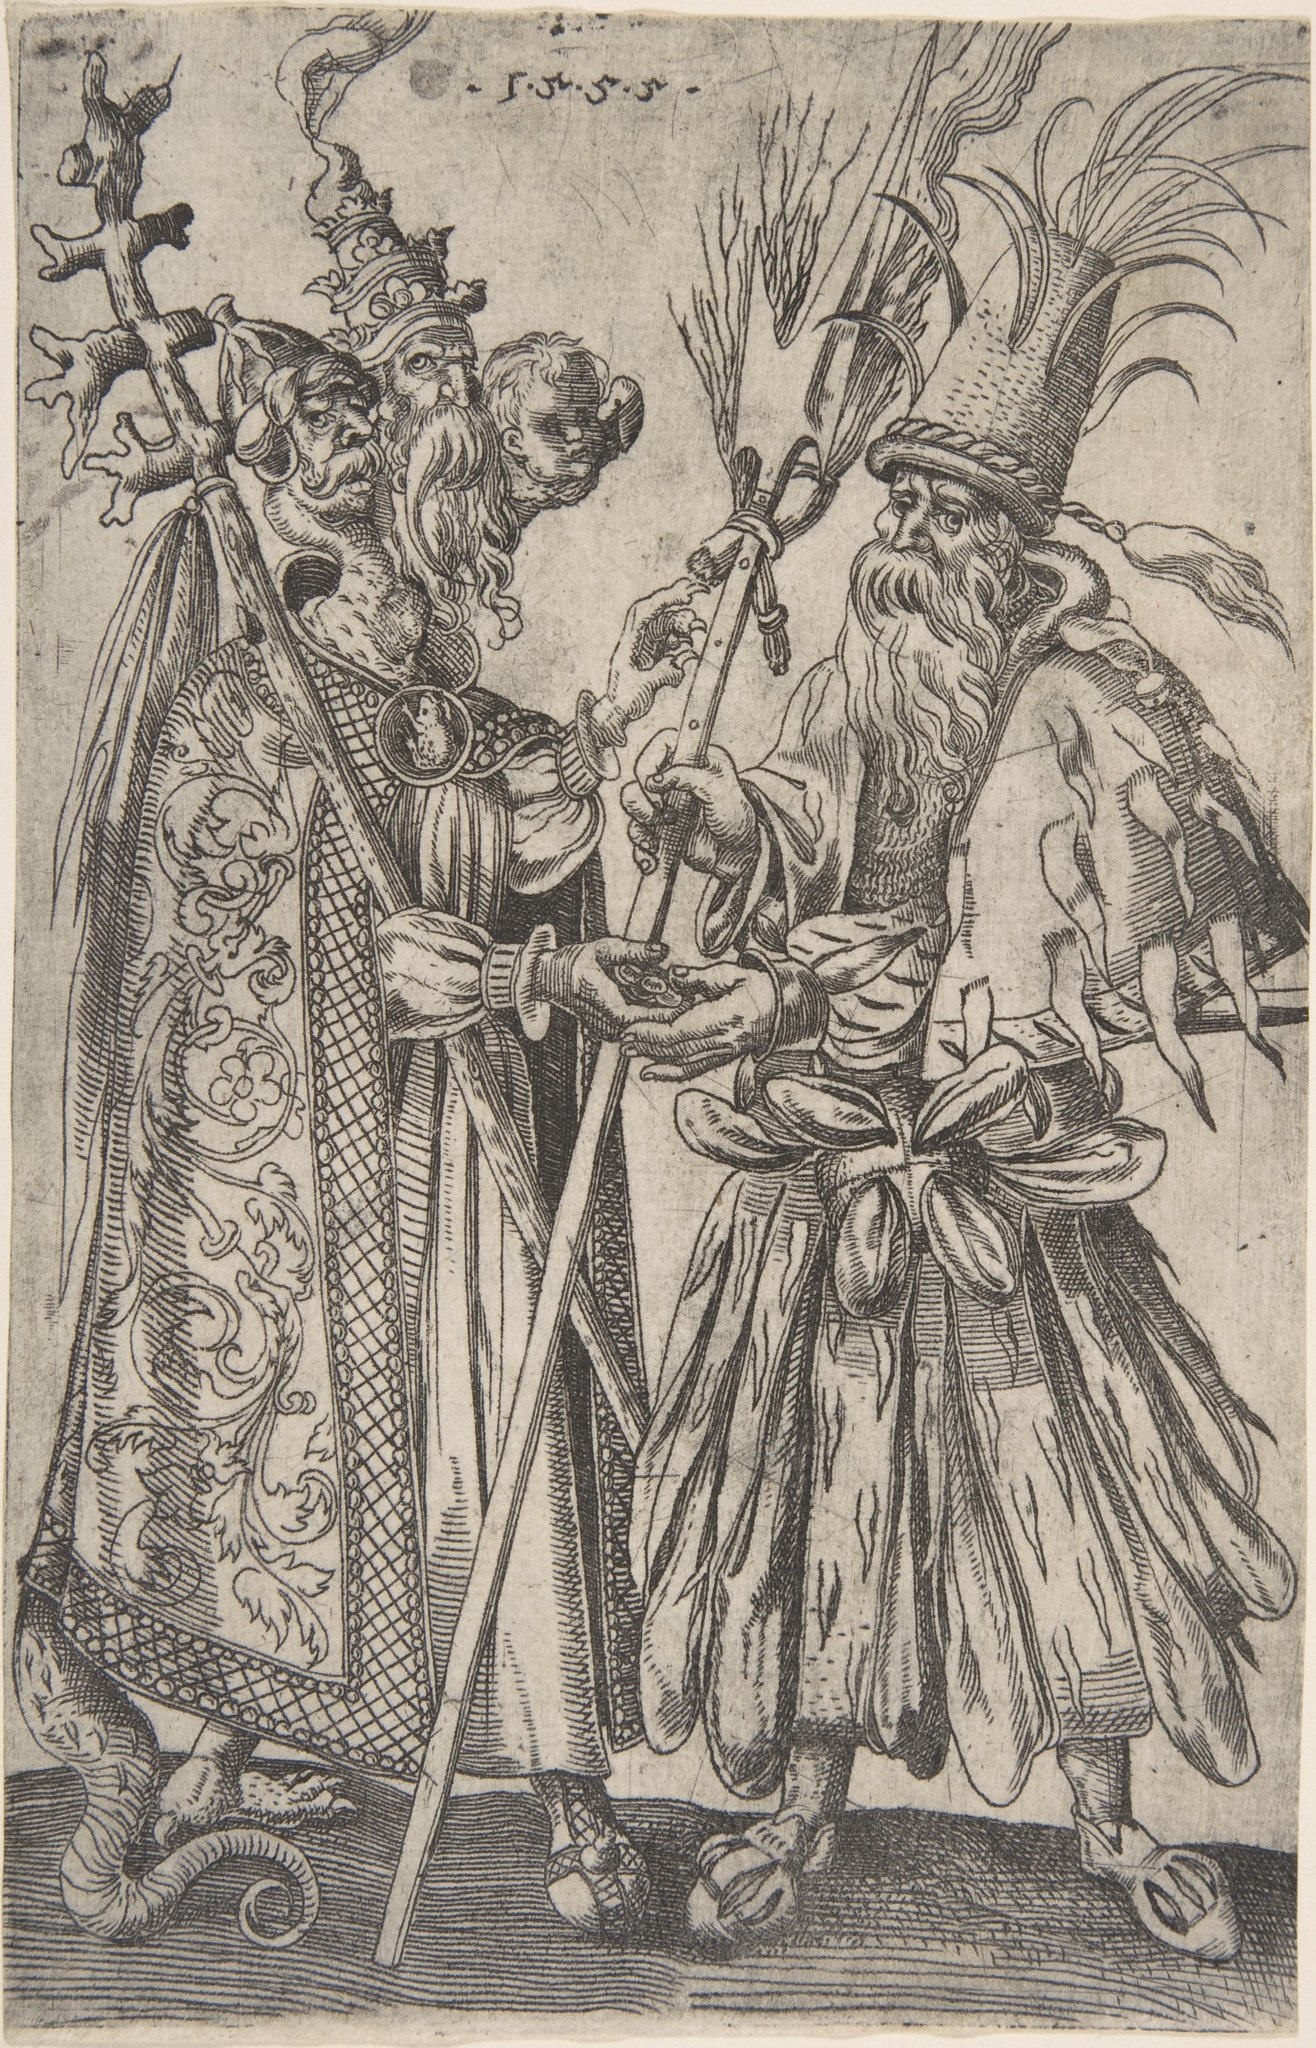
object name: print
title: Satire on the Papacy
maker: melchior lorck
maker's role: artist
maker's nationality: danish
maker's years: 1526-1588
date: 1555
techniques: etching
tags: satire,popes